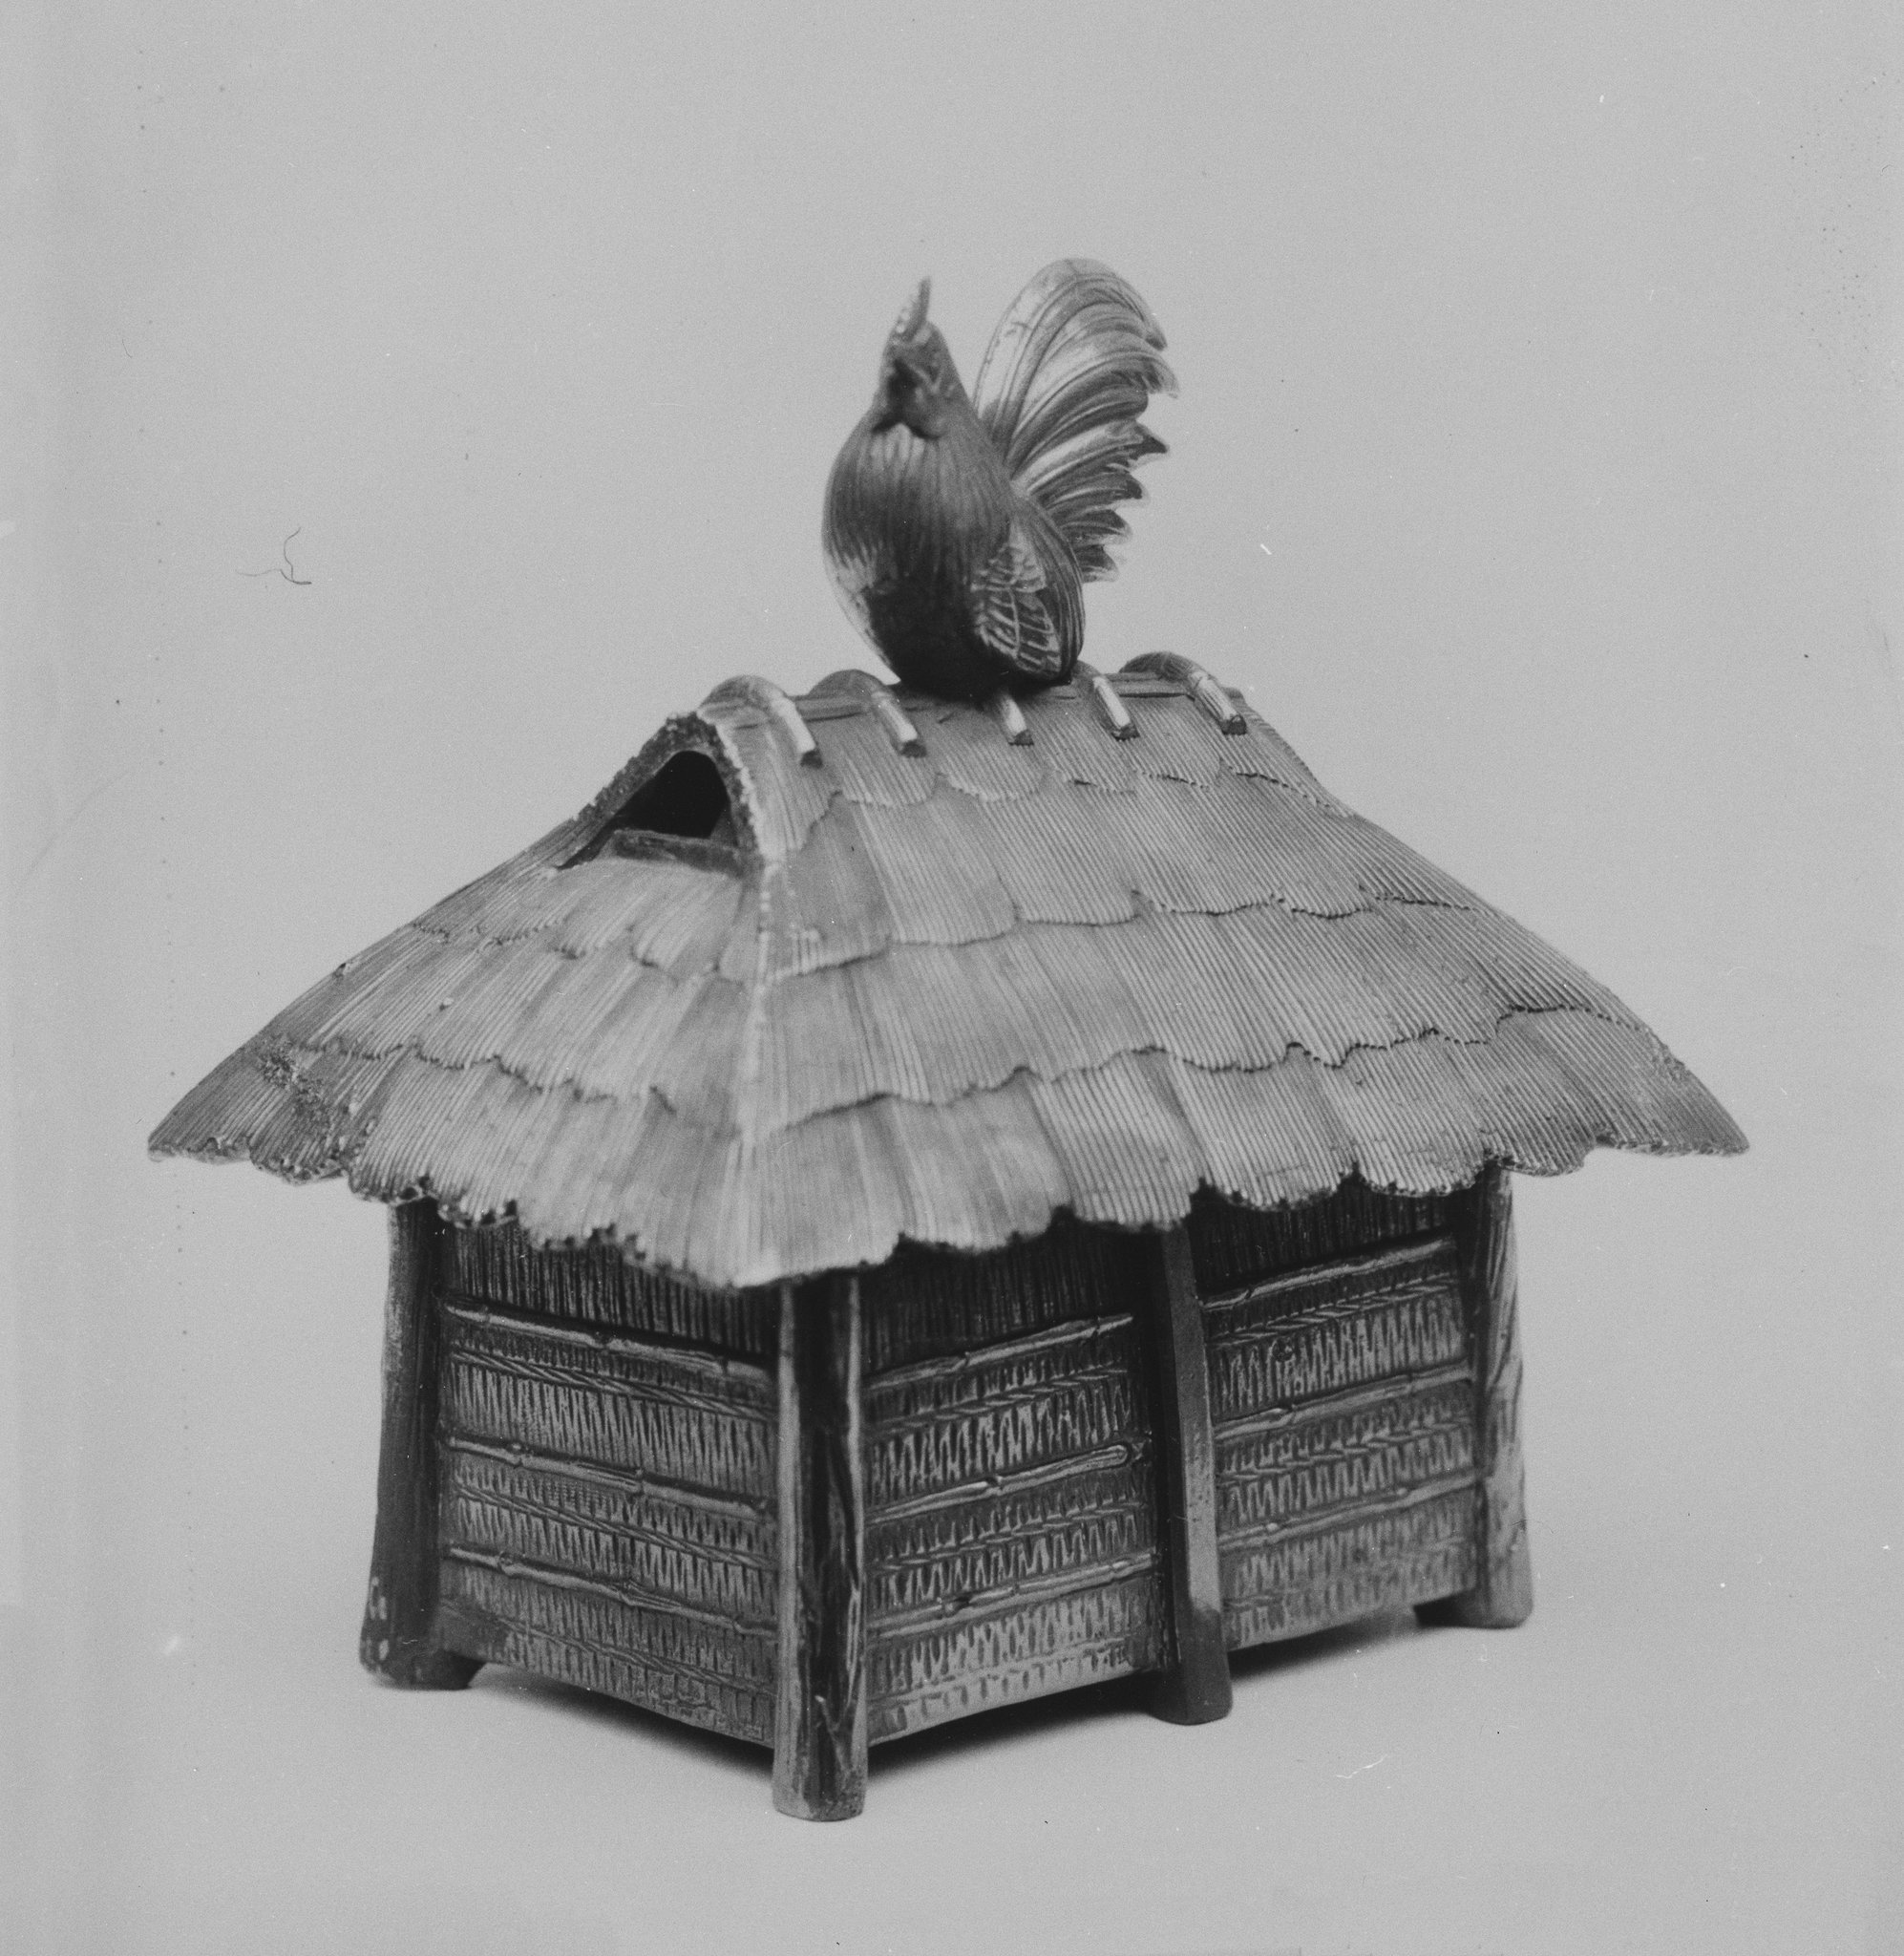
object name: censer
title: Censer in Form of a Rooster Perched on a Rooftop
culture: japanese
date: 1700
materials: glaze, stoneware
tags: houses,roosters,censers